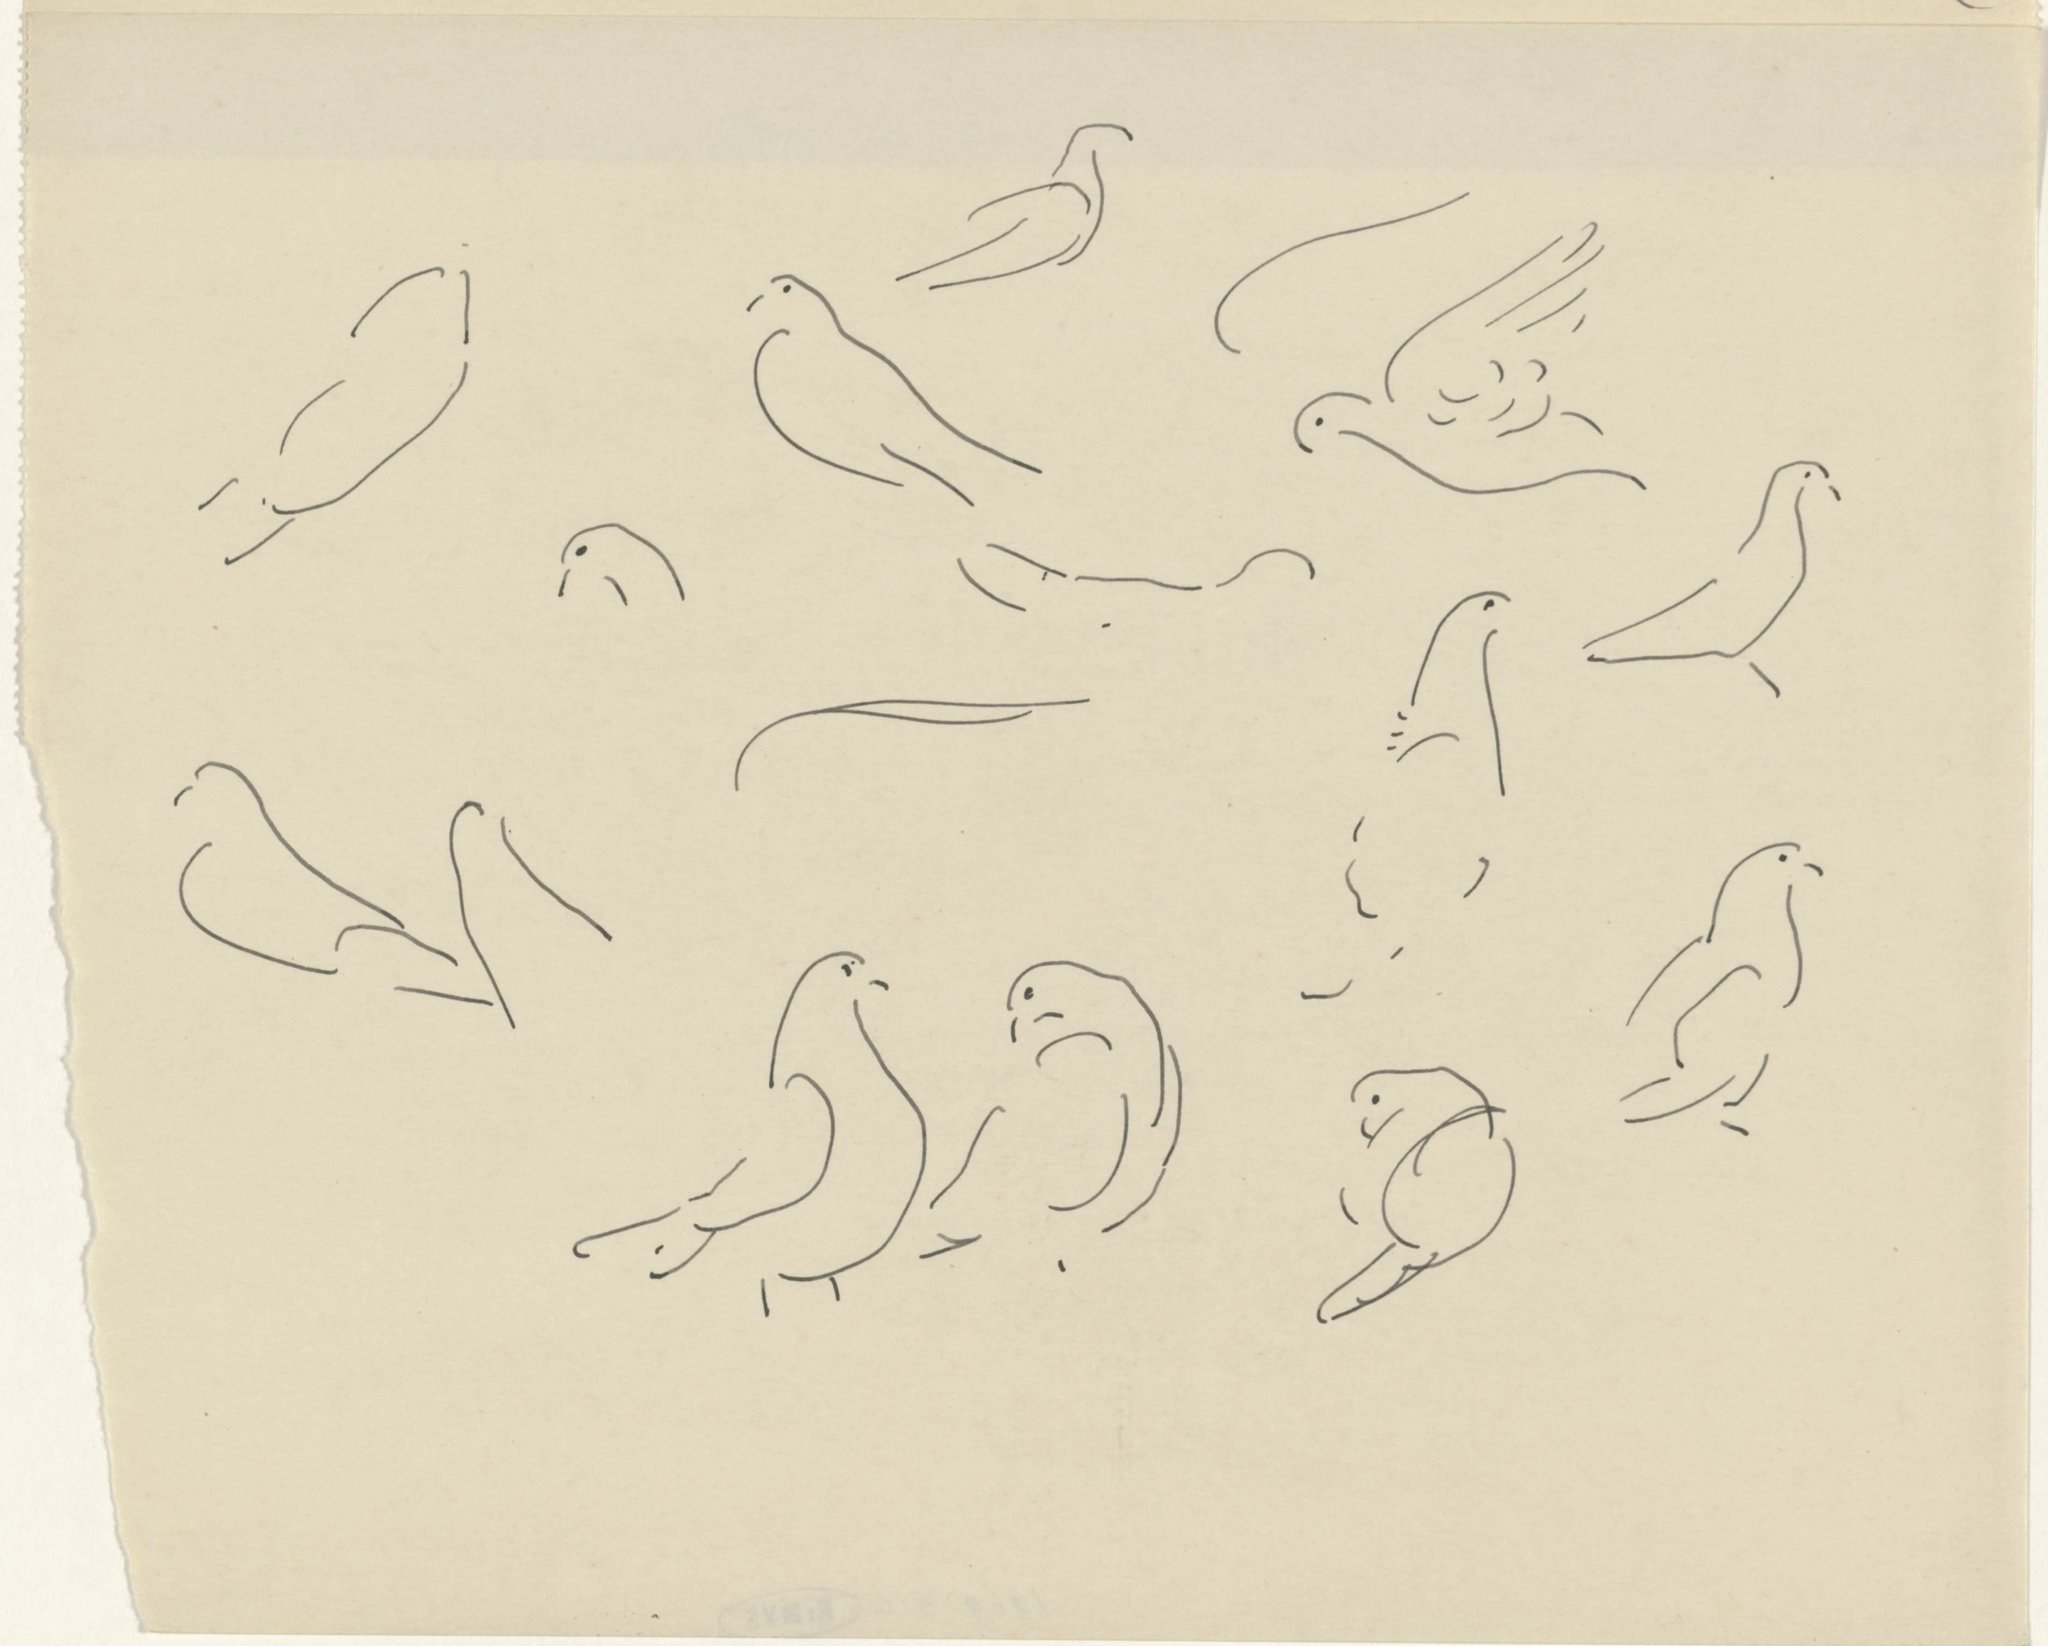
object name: drawing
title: Studies van duiven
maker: carel adolph lion cachet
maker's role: draughtsman, print maker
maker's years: 1864-1945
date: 1874-1945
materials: ink, paper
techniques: pen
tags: other birds: dove